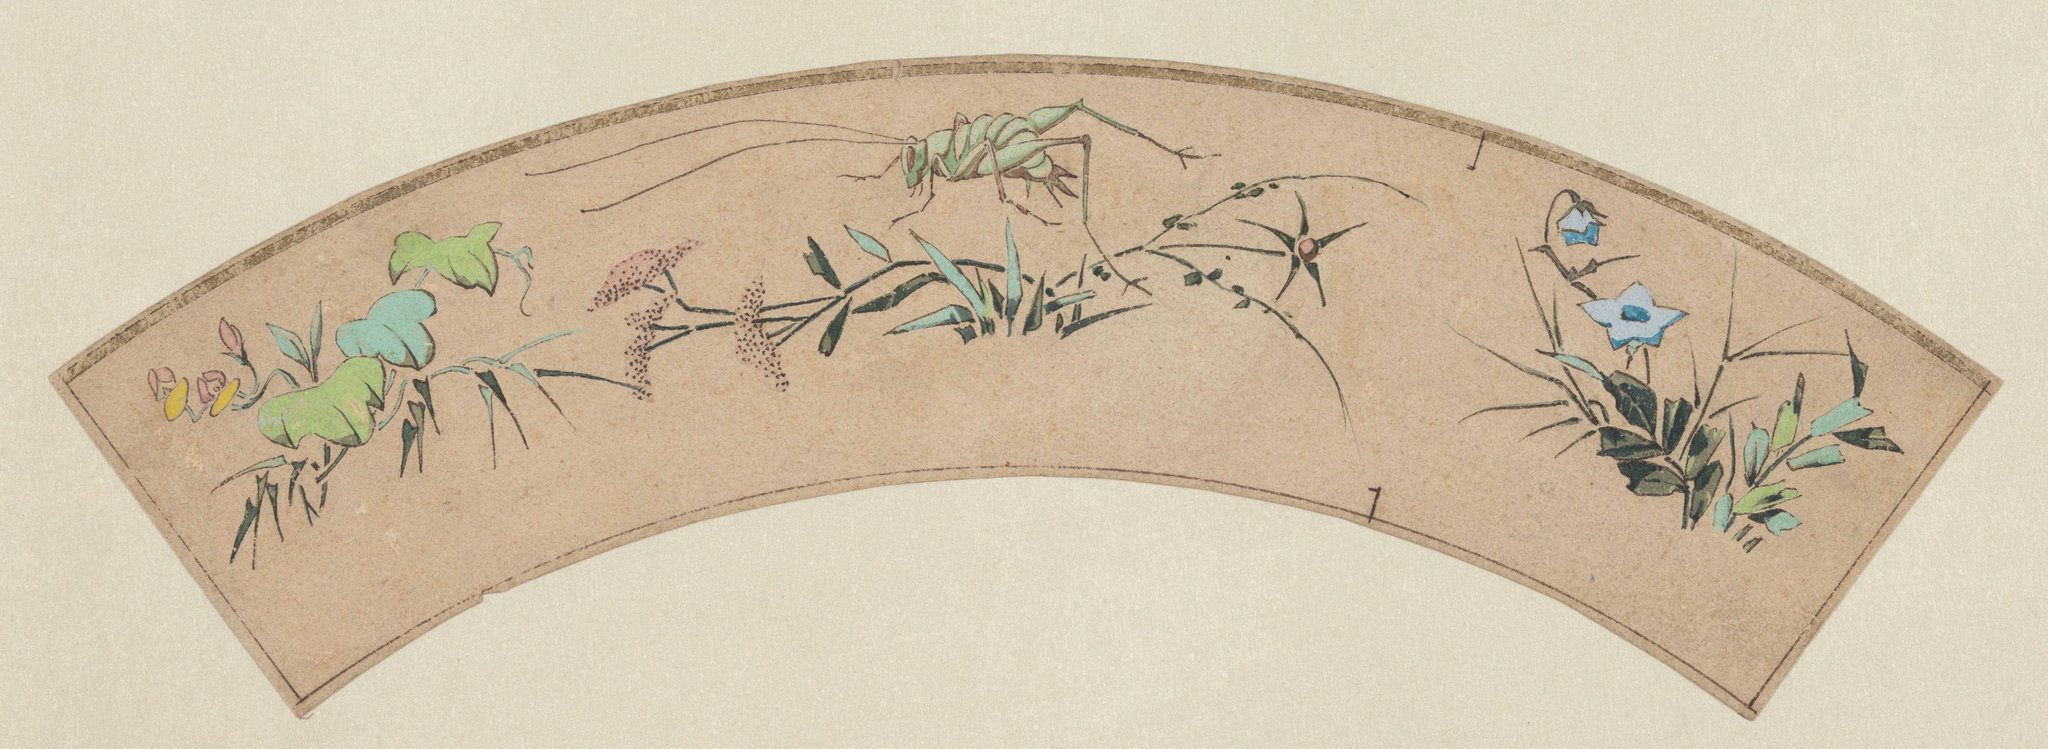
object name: design drawing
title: Ontwerp voor de beschildering van de rand van een schotel of de wand van een eierdop, beker of kop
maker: eugène louis millet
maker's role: architect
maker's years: 1819-1879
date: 1875-1890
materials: gouache, ink, paper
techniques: brush, pen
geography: bordeaux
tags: ornament derived from plant forms